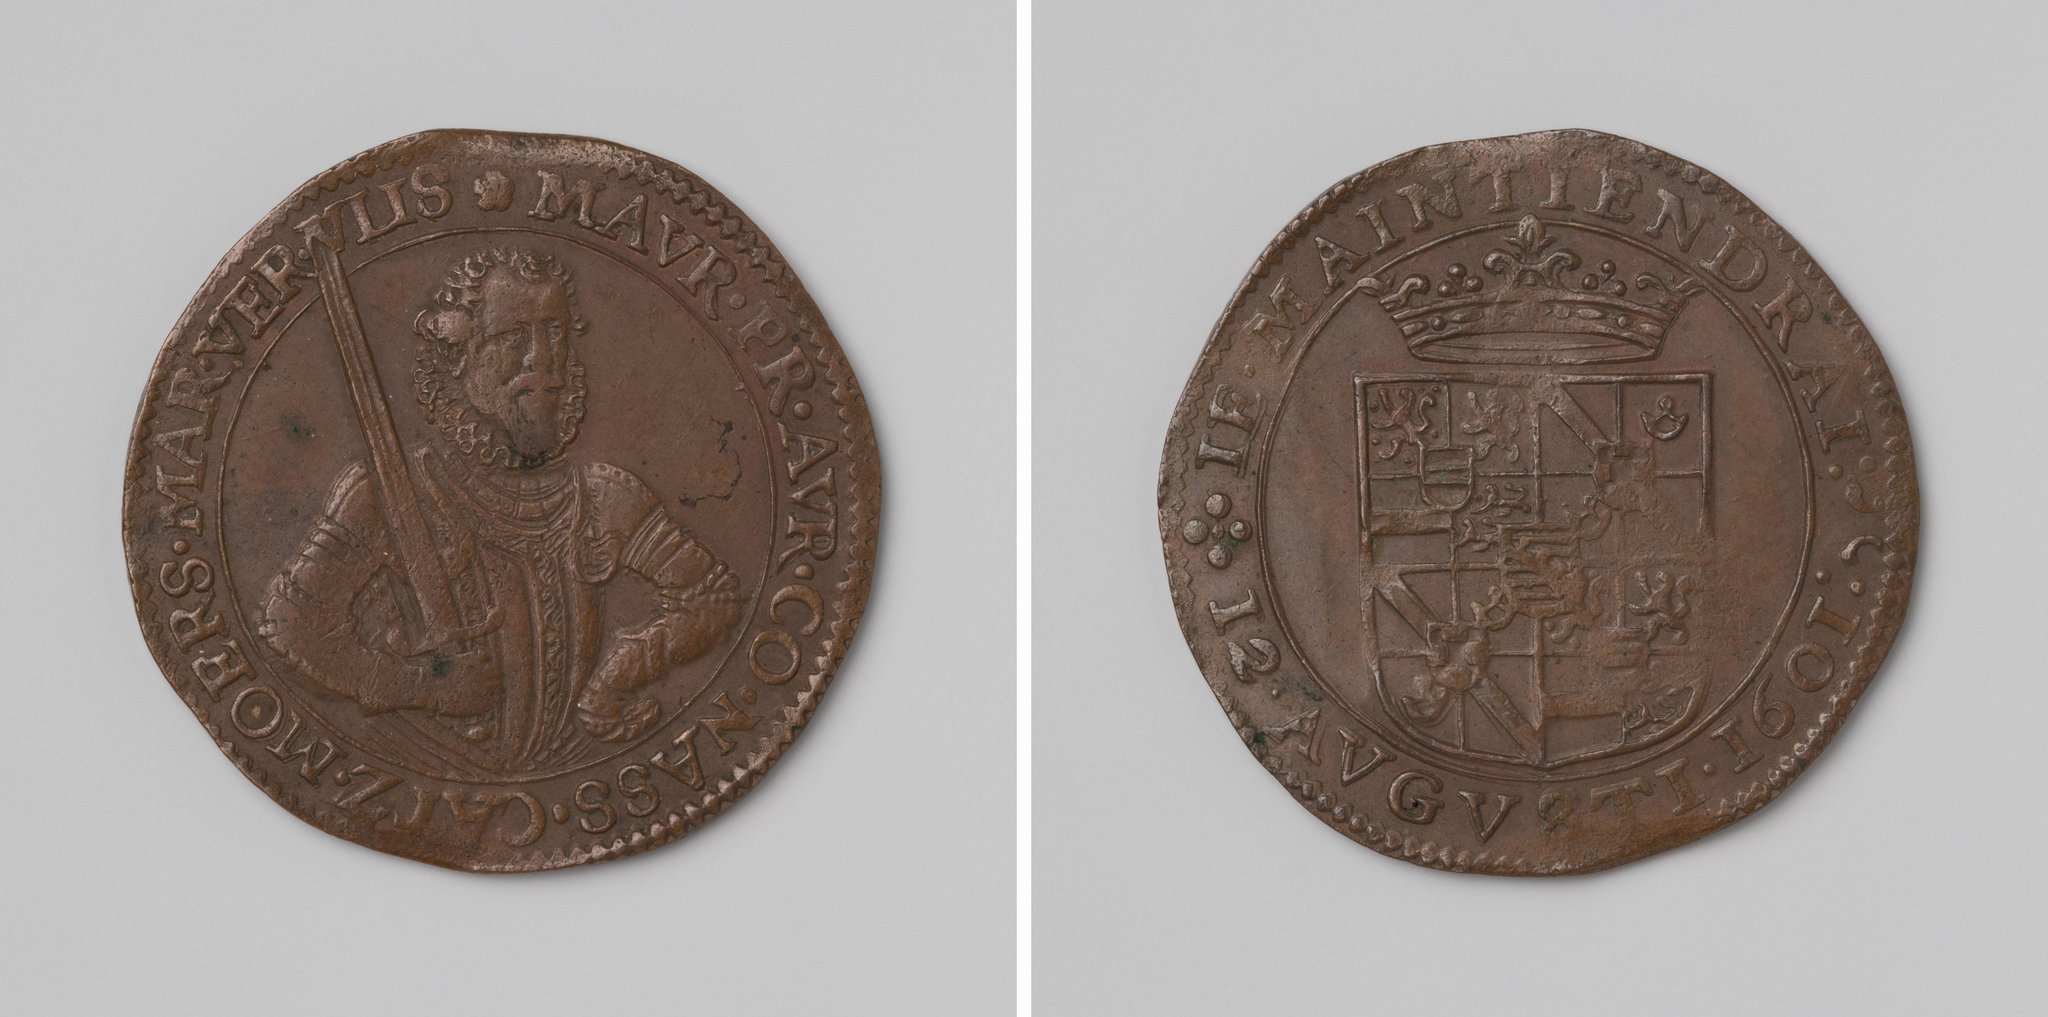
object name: jeton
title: Maurits, graaf van Nassau, ingehuldigd als graaf van Moers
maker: Anonymous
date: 1601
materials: copper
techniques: striking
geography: dordrecht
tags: the hague, maurice (prince of orange)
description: Koperen penning. Voorzijde: portret man met zwaard in rechterhand, rustend op schouder binnen omschrift. Keerzijde: gekroond wapenschild binnen omschrift